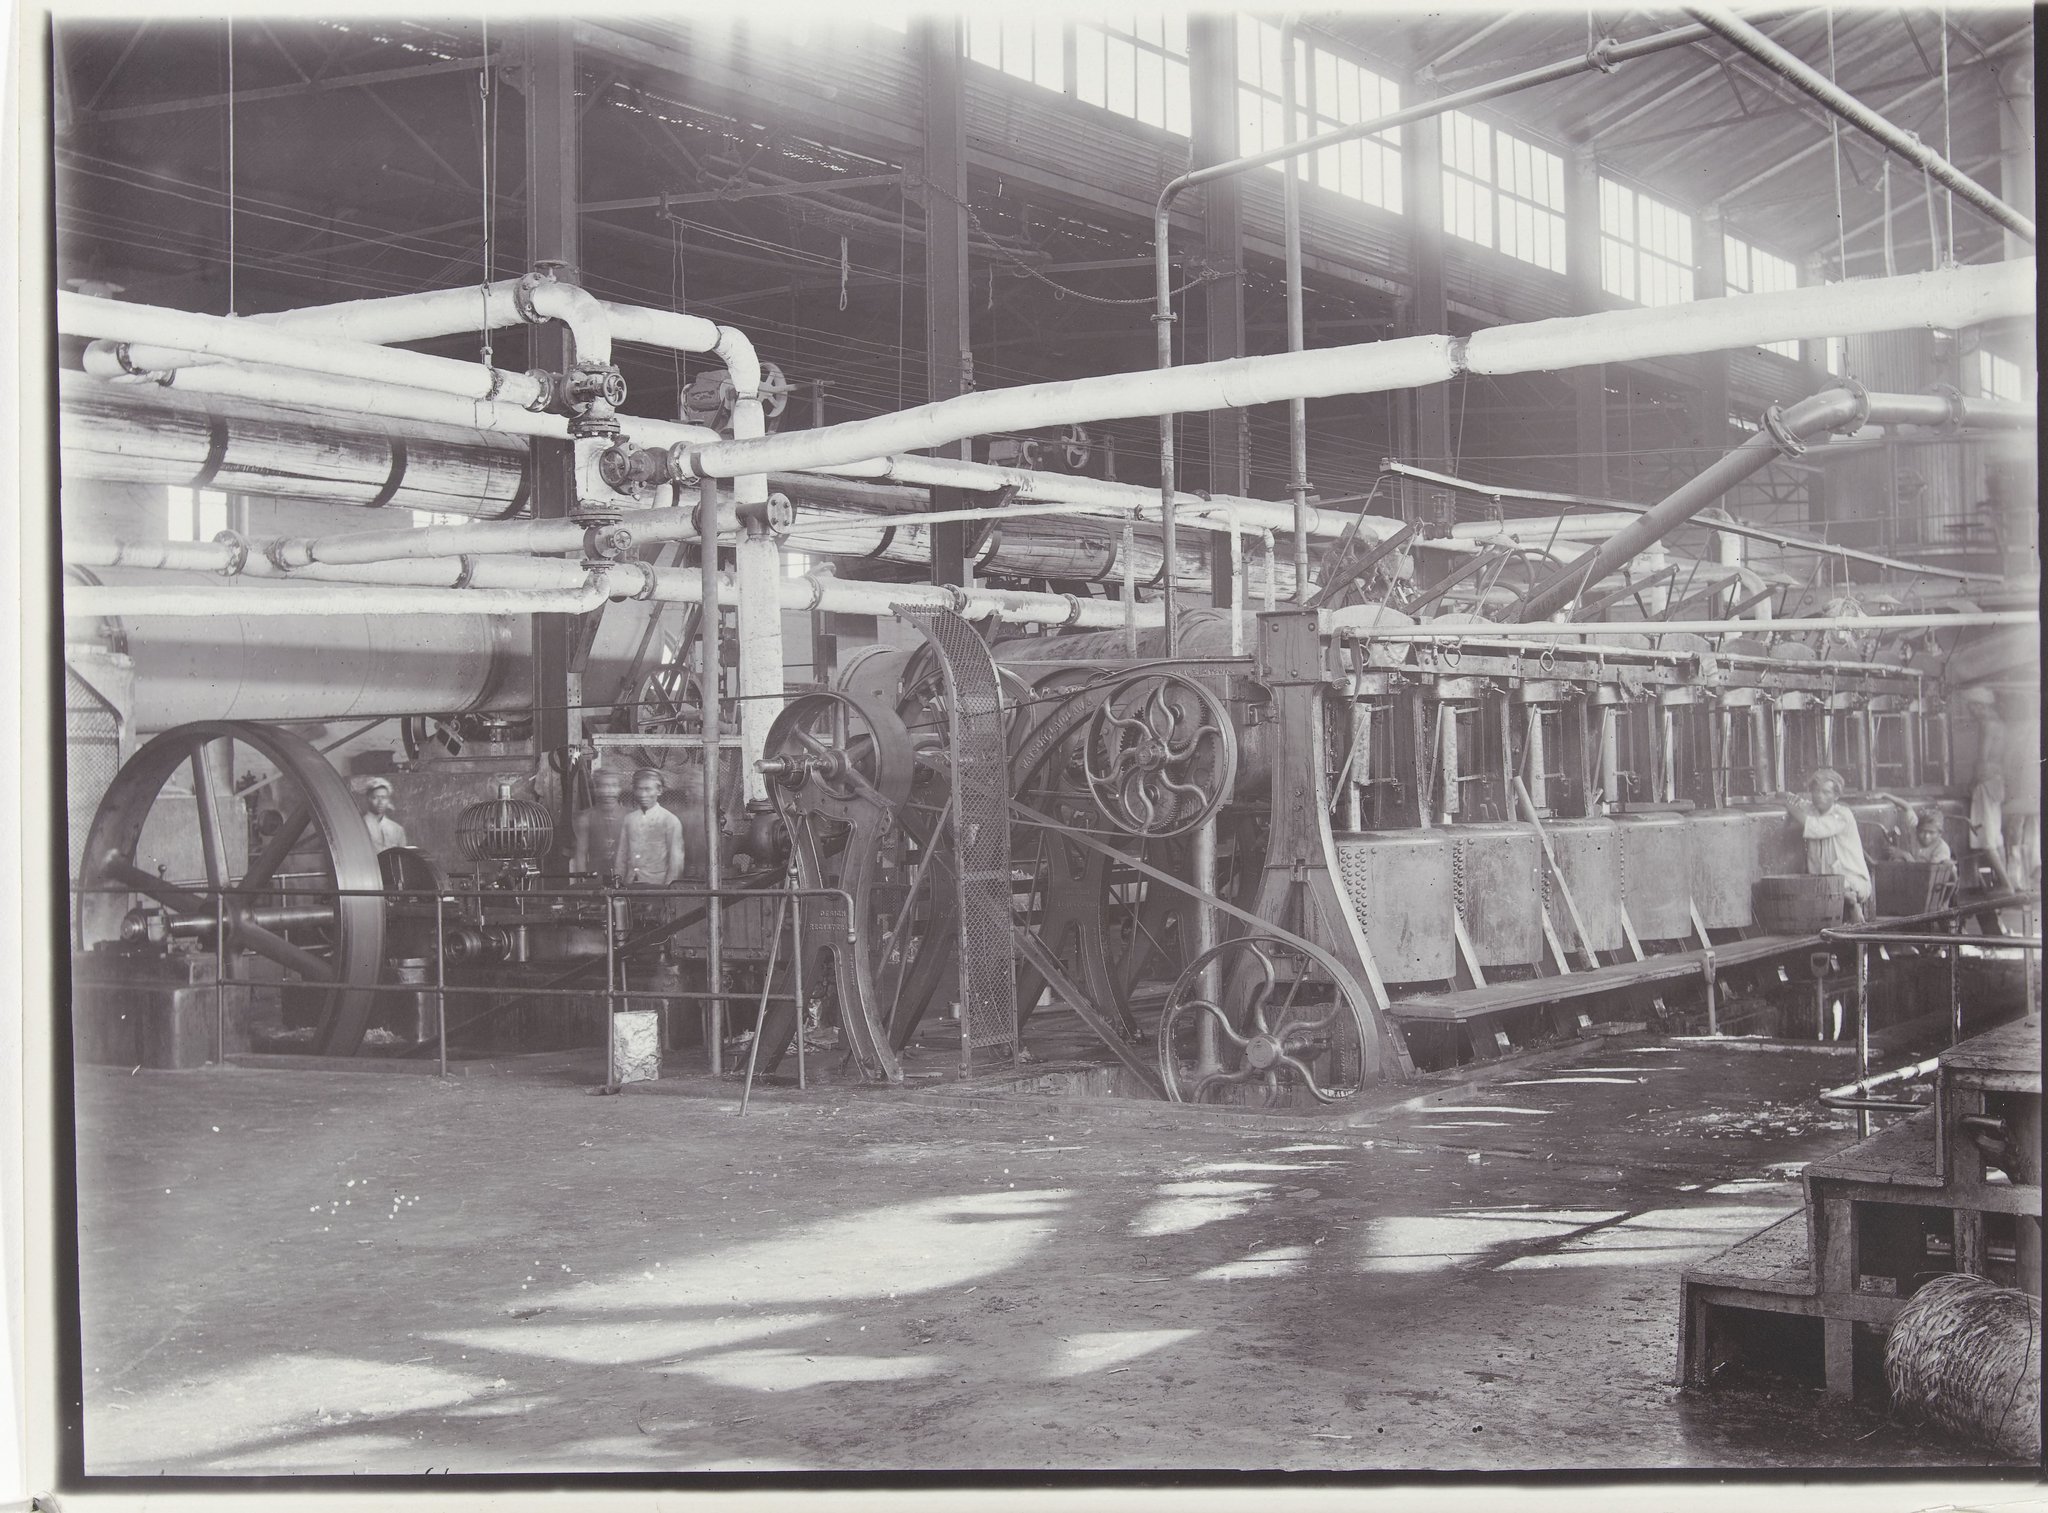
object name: photograph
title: Interieur van de fabriek op de suikeronderneming Nieuw Tersana, Cheribon, voormalig Nederlands-Indië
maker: onnes kurkdjian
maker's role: fotograaf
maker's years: 1851-1903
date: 1890-1911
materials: paper, photographic support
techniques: gelatin silver print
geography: cirebon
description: Interieur van de fabriek op de suikeronderneming Nieuw Tersana, Cheribon, voormalig Nederlands-Indië. Verschillende mannen bedien de machines.